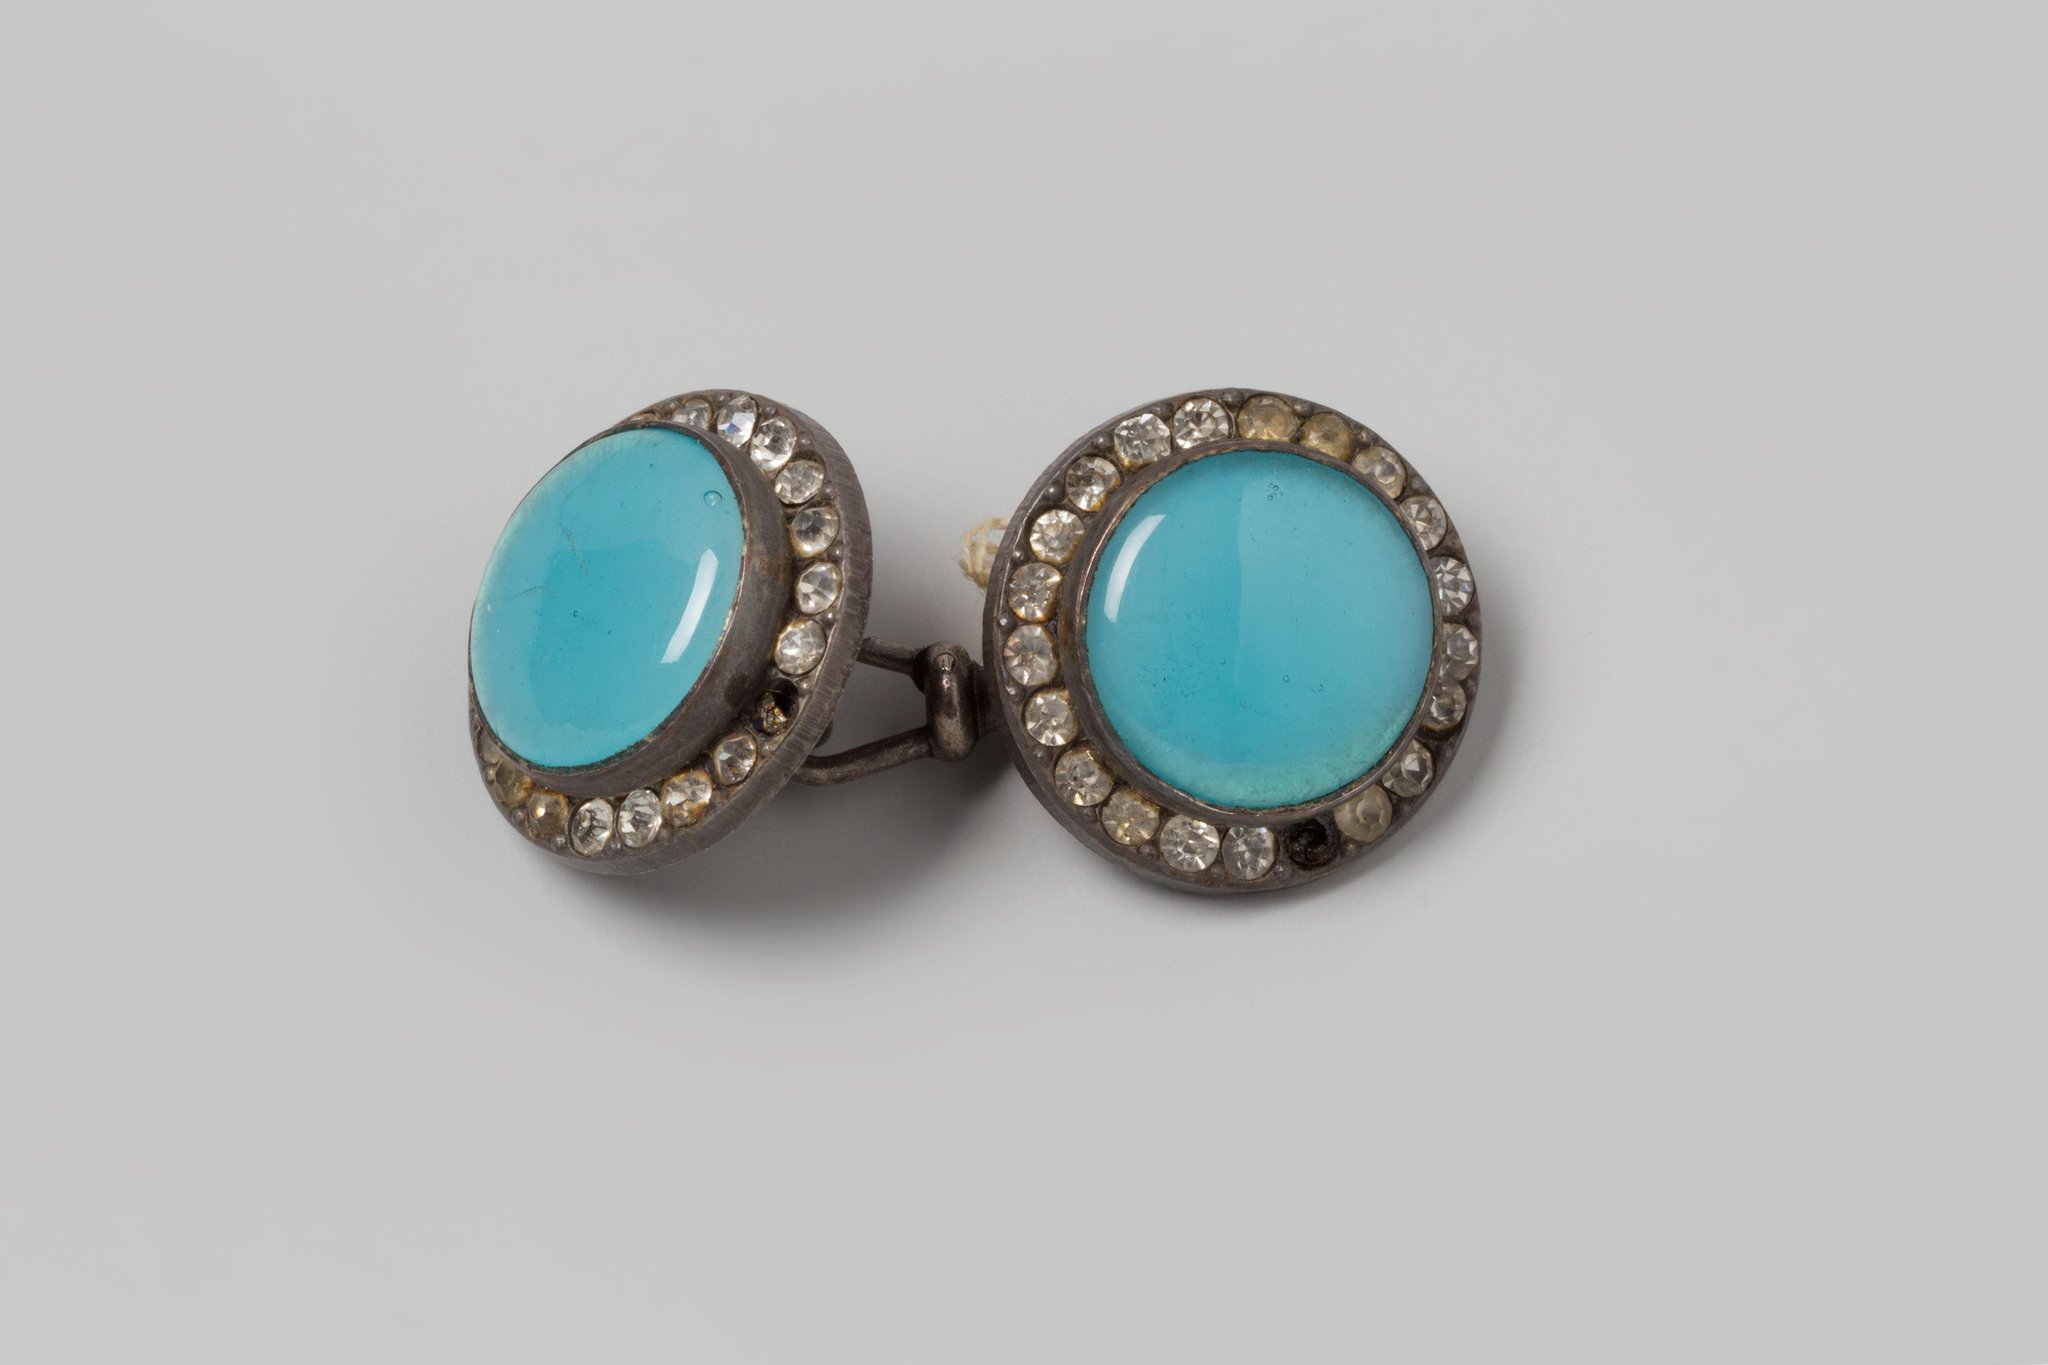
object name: clothing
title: Manchetknoop bestaande uit een lichtblauwe bolronde steen met een omlijsting van strasstenen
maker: Anonymous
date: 1900-1950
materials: metal, paste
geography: netherlands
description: Ronde manchetknoop bestaande uit een lichtblauwe bolronde steen met een omlijsting van strasstenen. Aan de achterzijde een oogje.